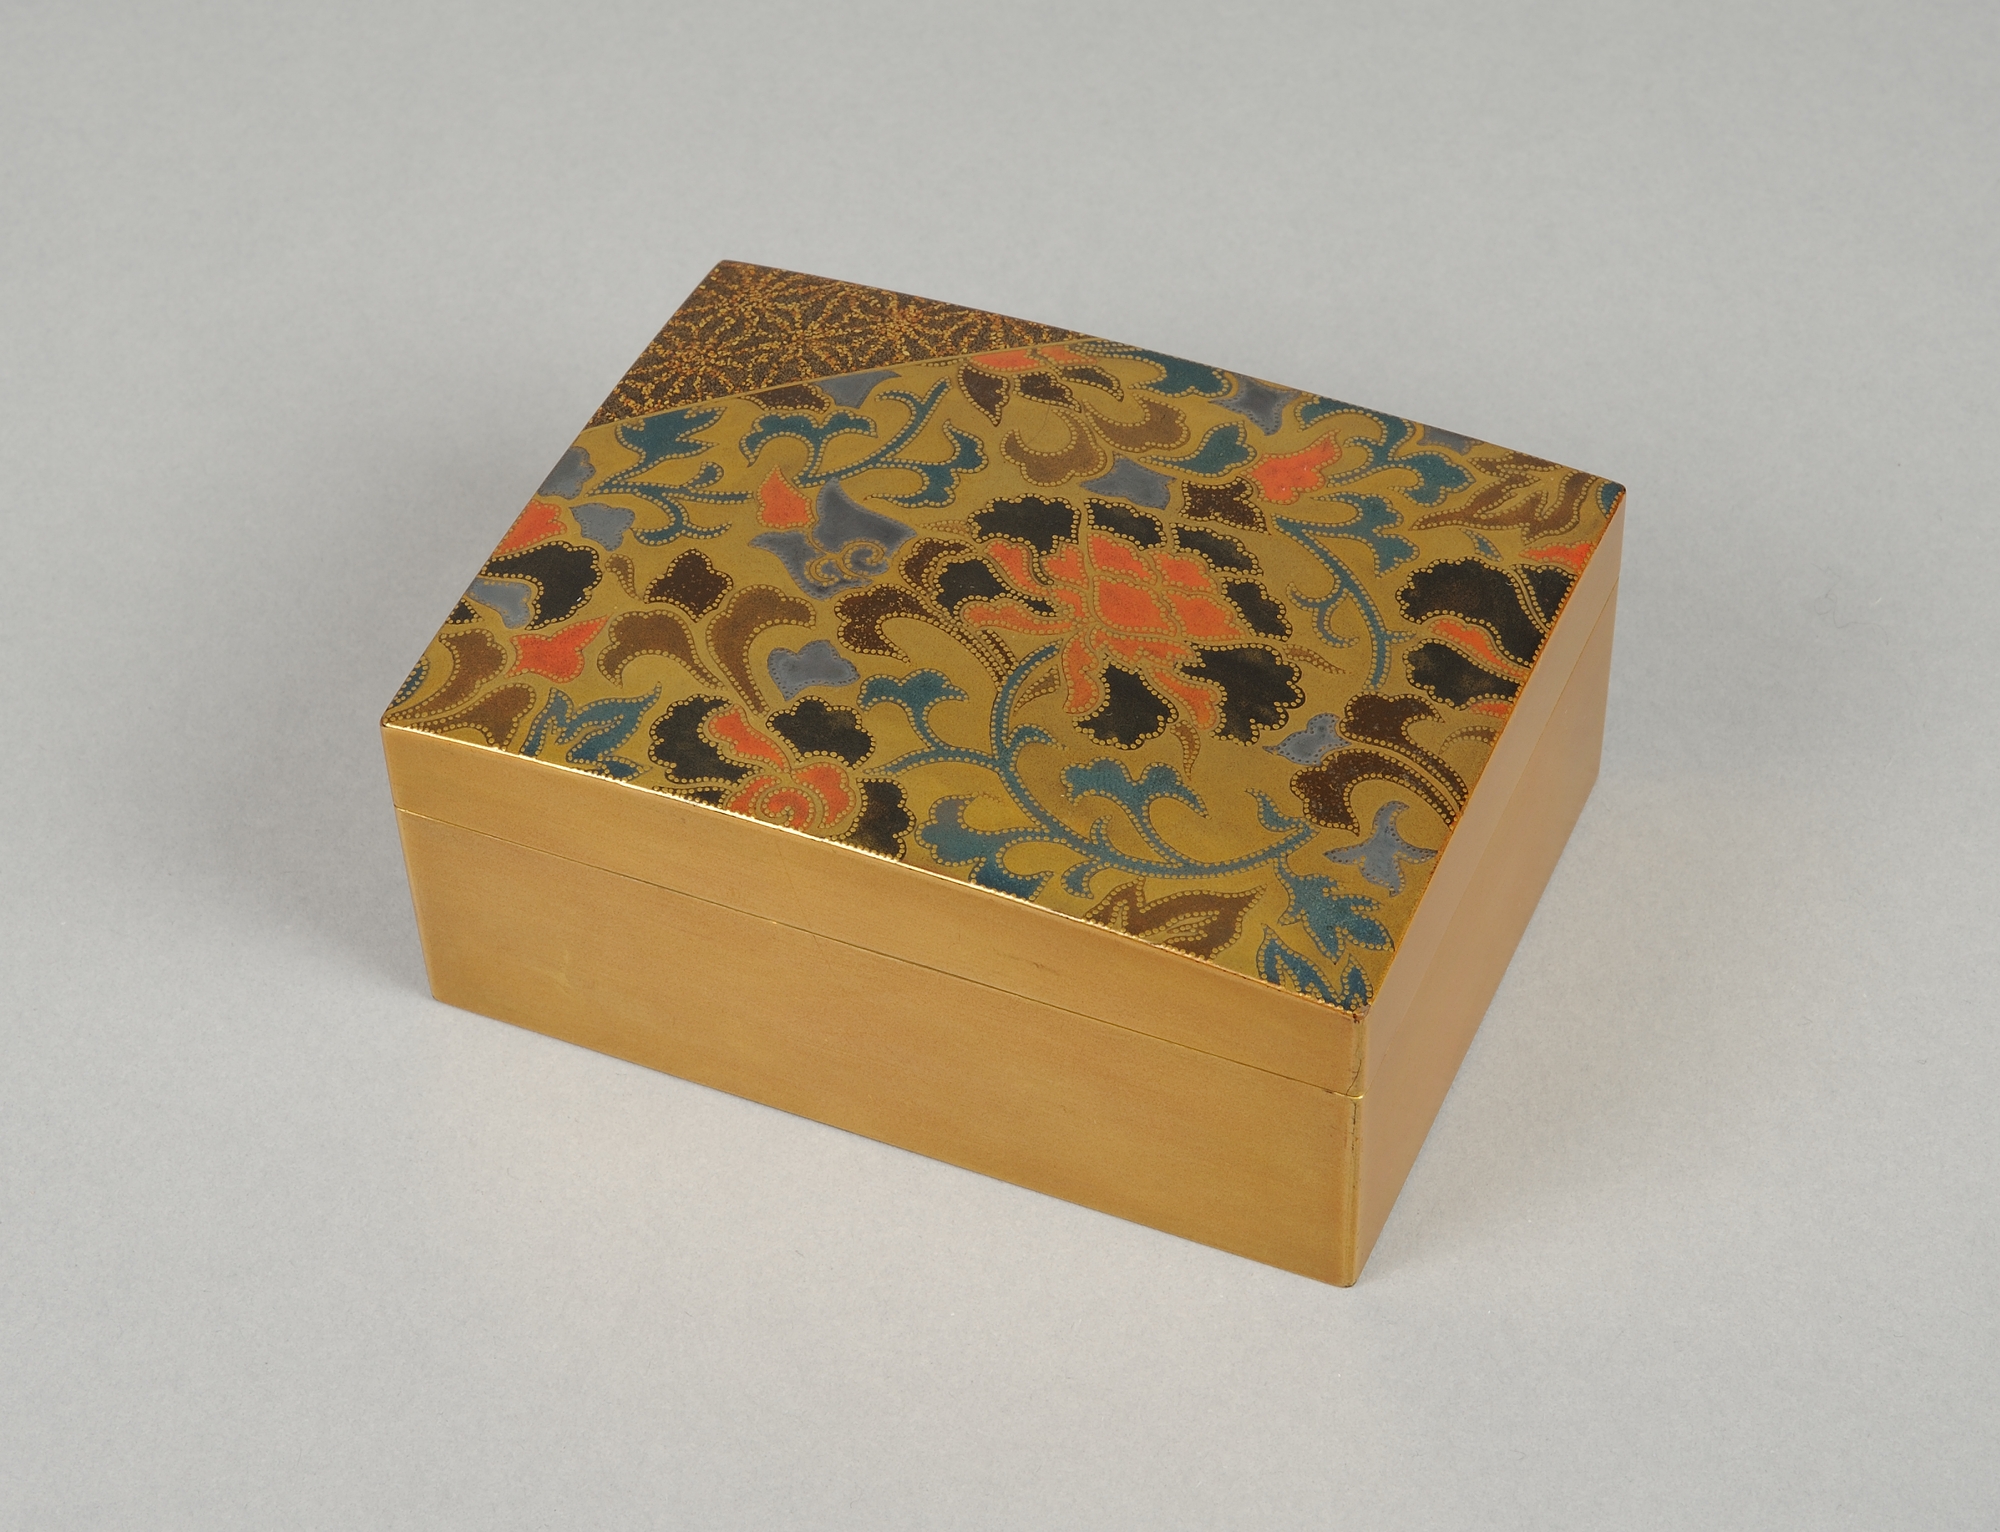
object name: box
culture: japanese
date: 1867-1900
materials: lacquer